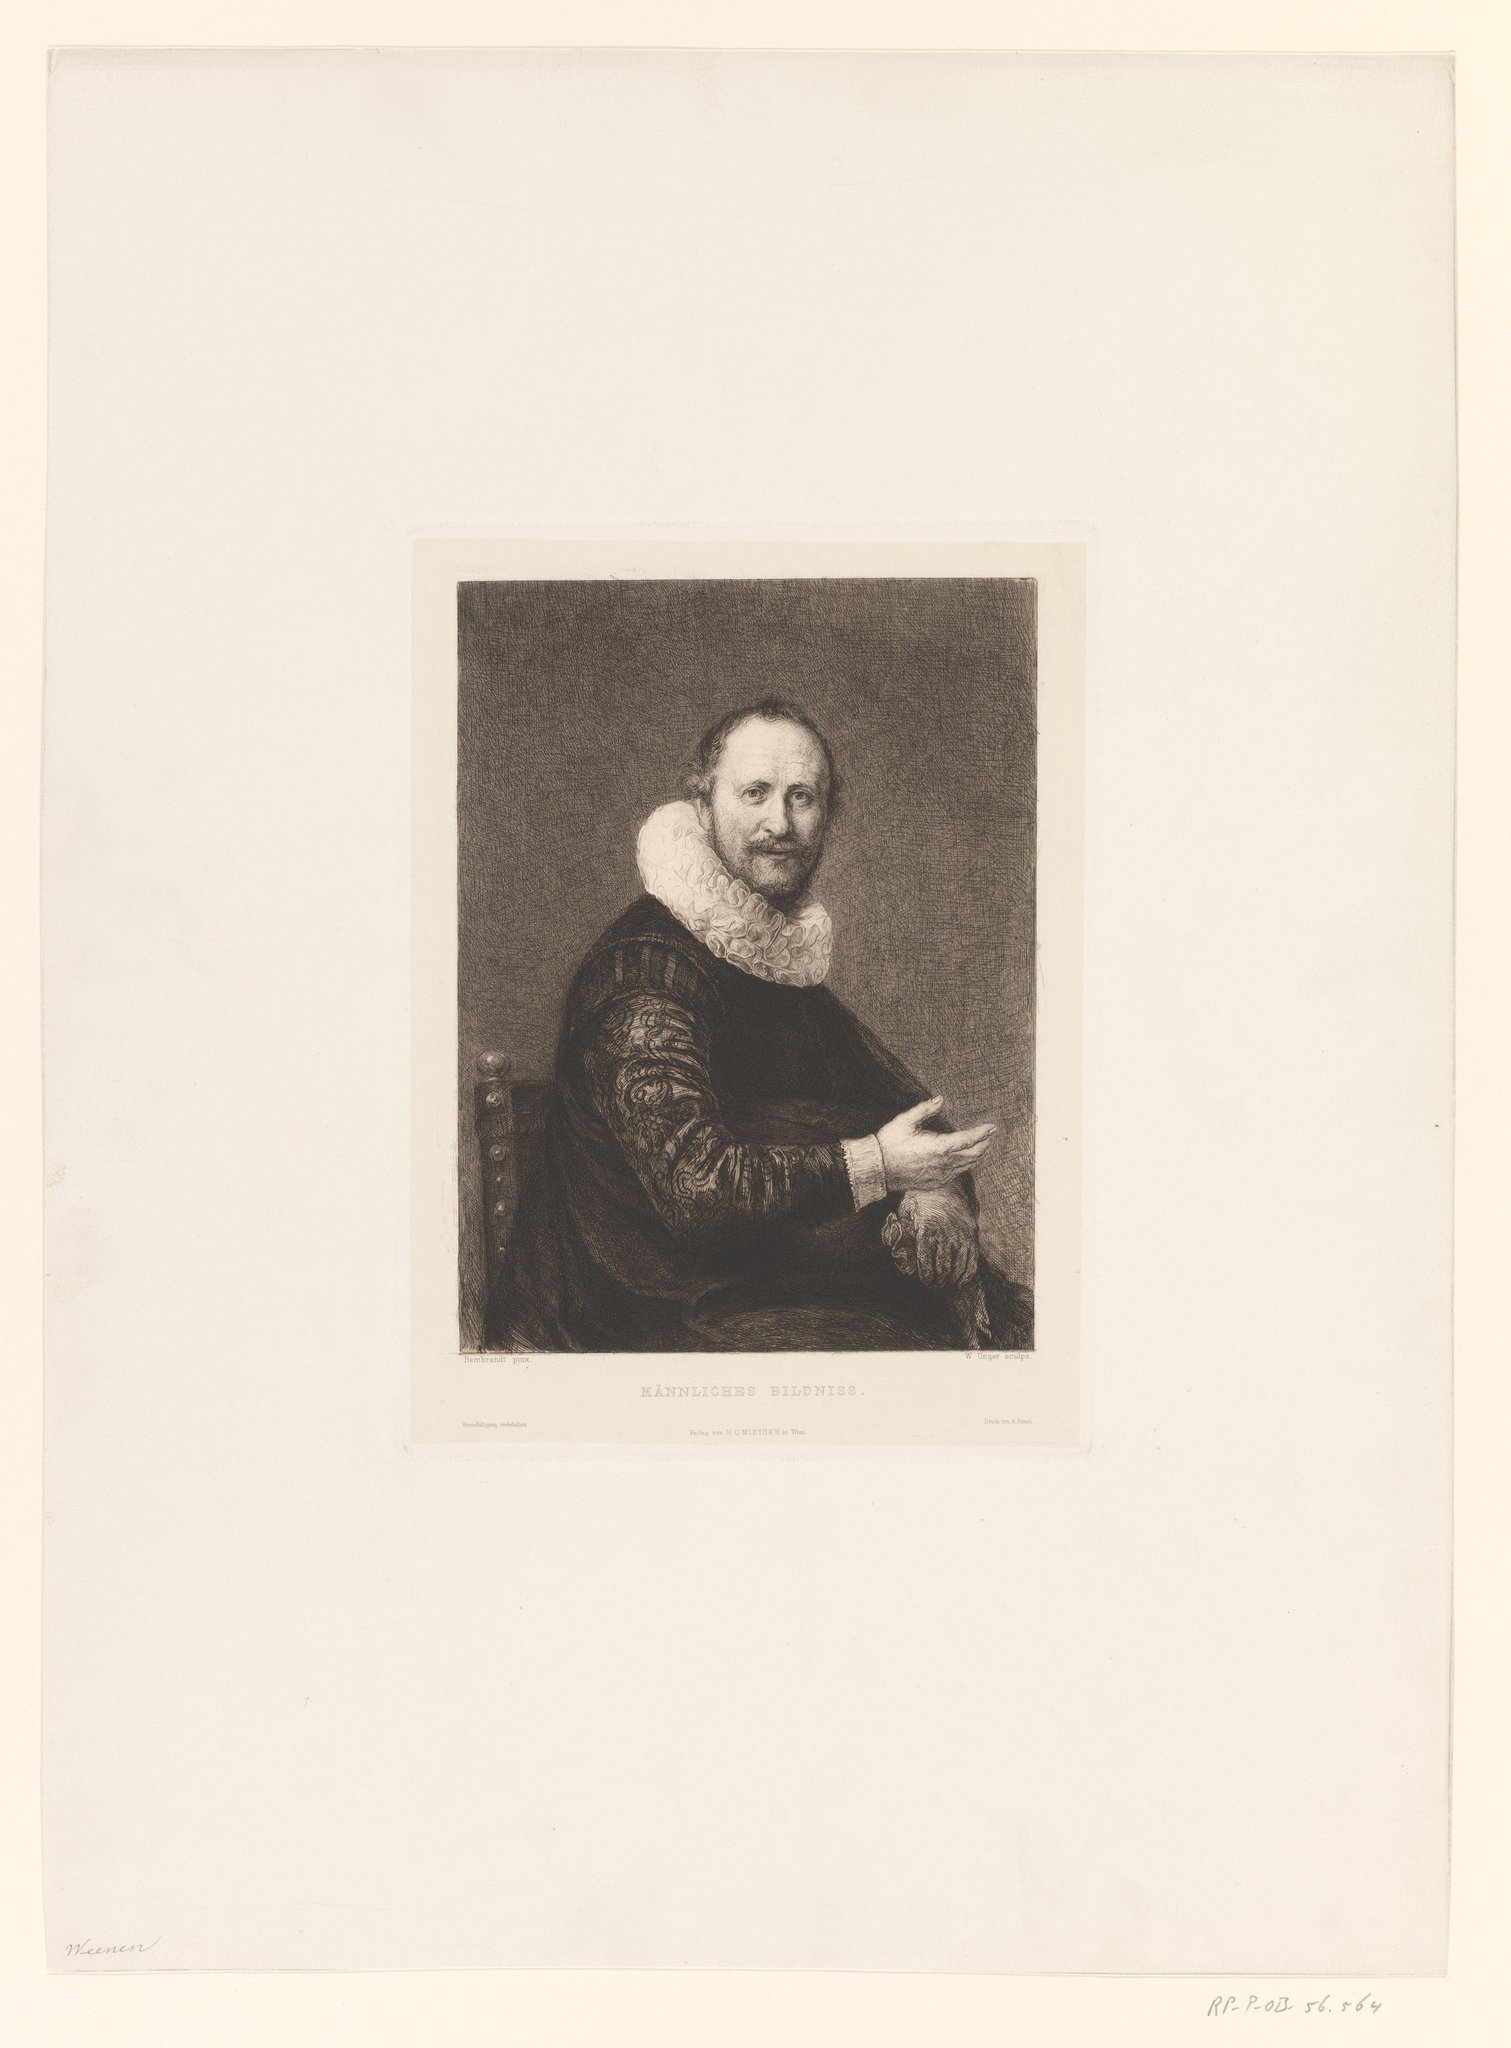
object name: print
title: Männliches Bildniss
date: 1861-1889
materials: paper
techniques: etching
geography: vienna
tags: historical persons not known by name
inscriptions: collector's mark: Lugt 2228